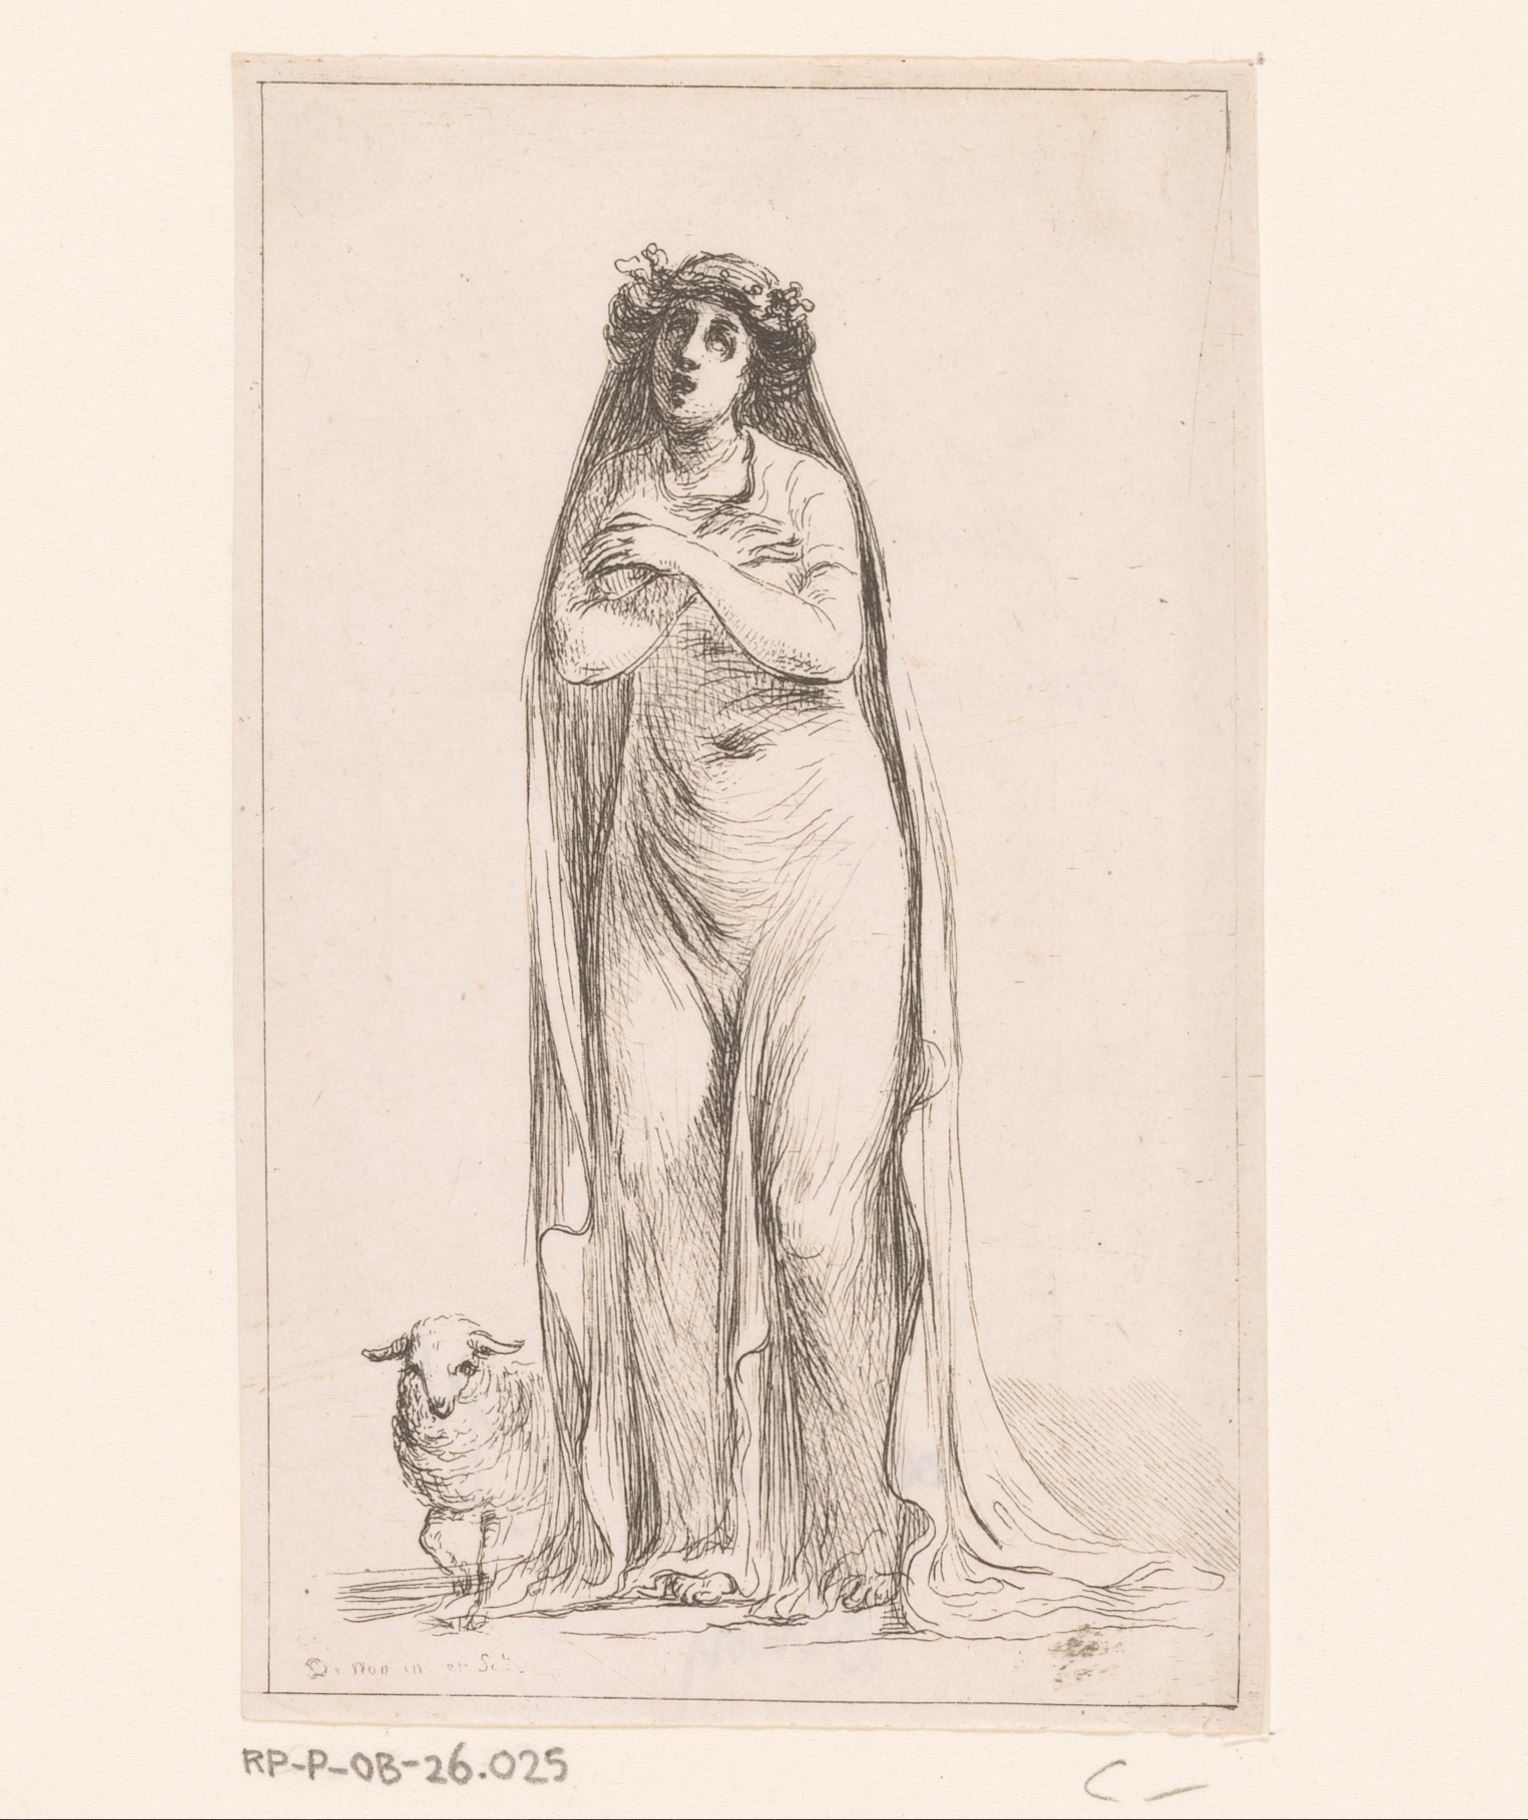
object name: print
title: Vrouw met sluier en naast zich een lam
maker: richard de saint-non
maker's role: print maker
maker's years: 1727-1791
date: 1737-1791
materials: paper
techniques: etching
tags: the marriage of the lamb, lamb, veil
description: Mogelijk een verbeelding van de bruiloft van het Lam, uit Openbaring 19:6-10.